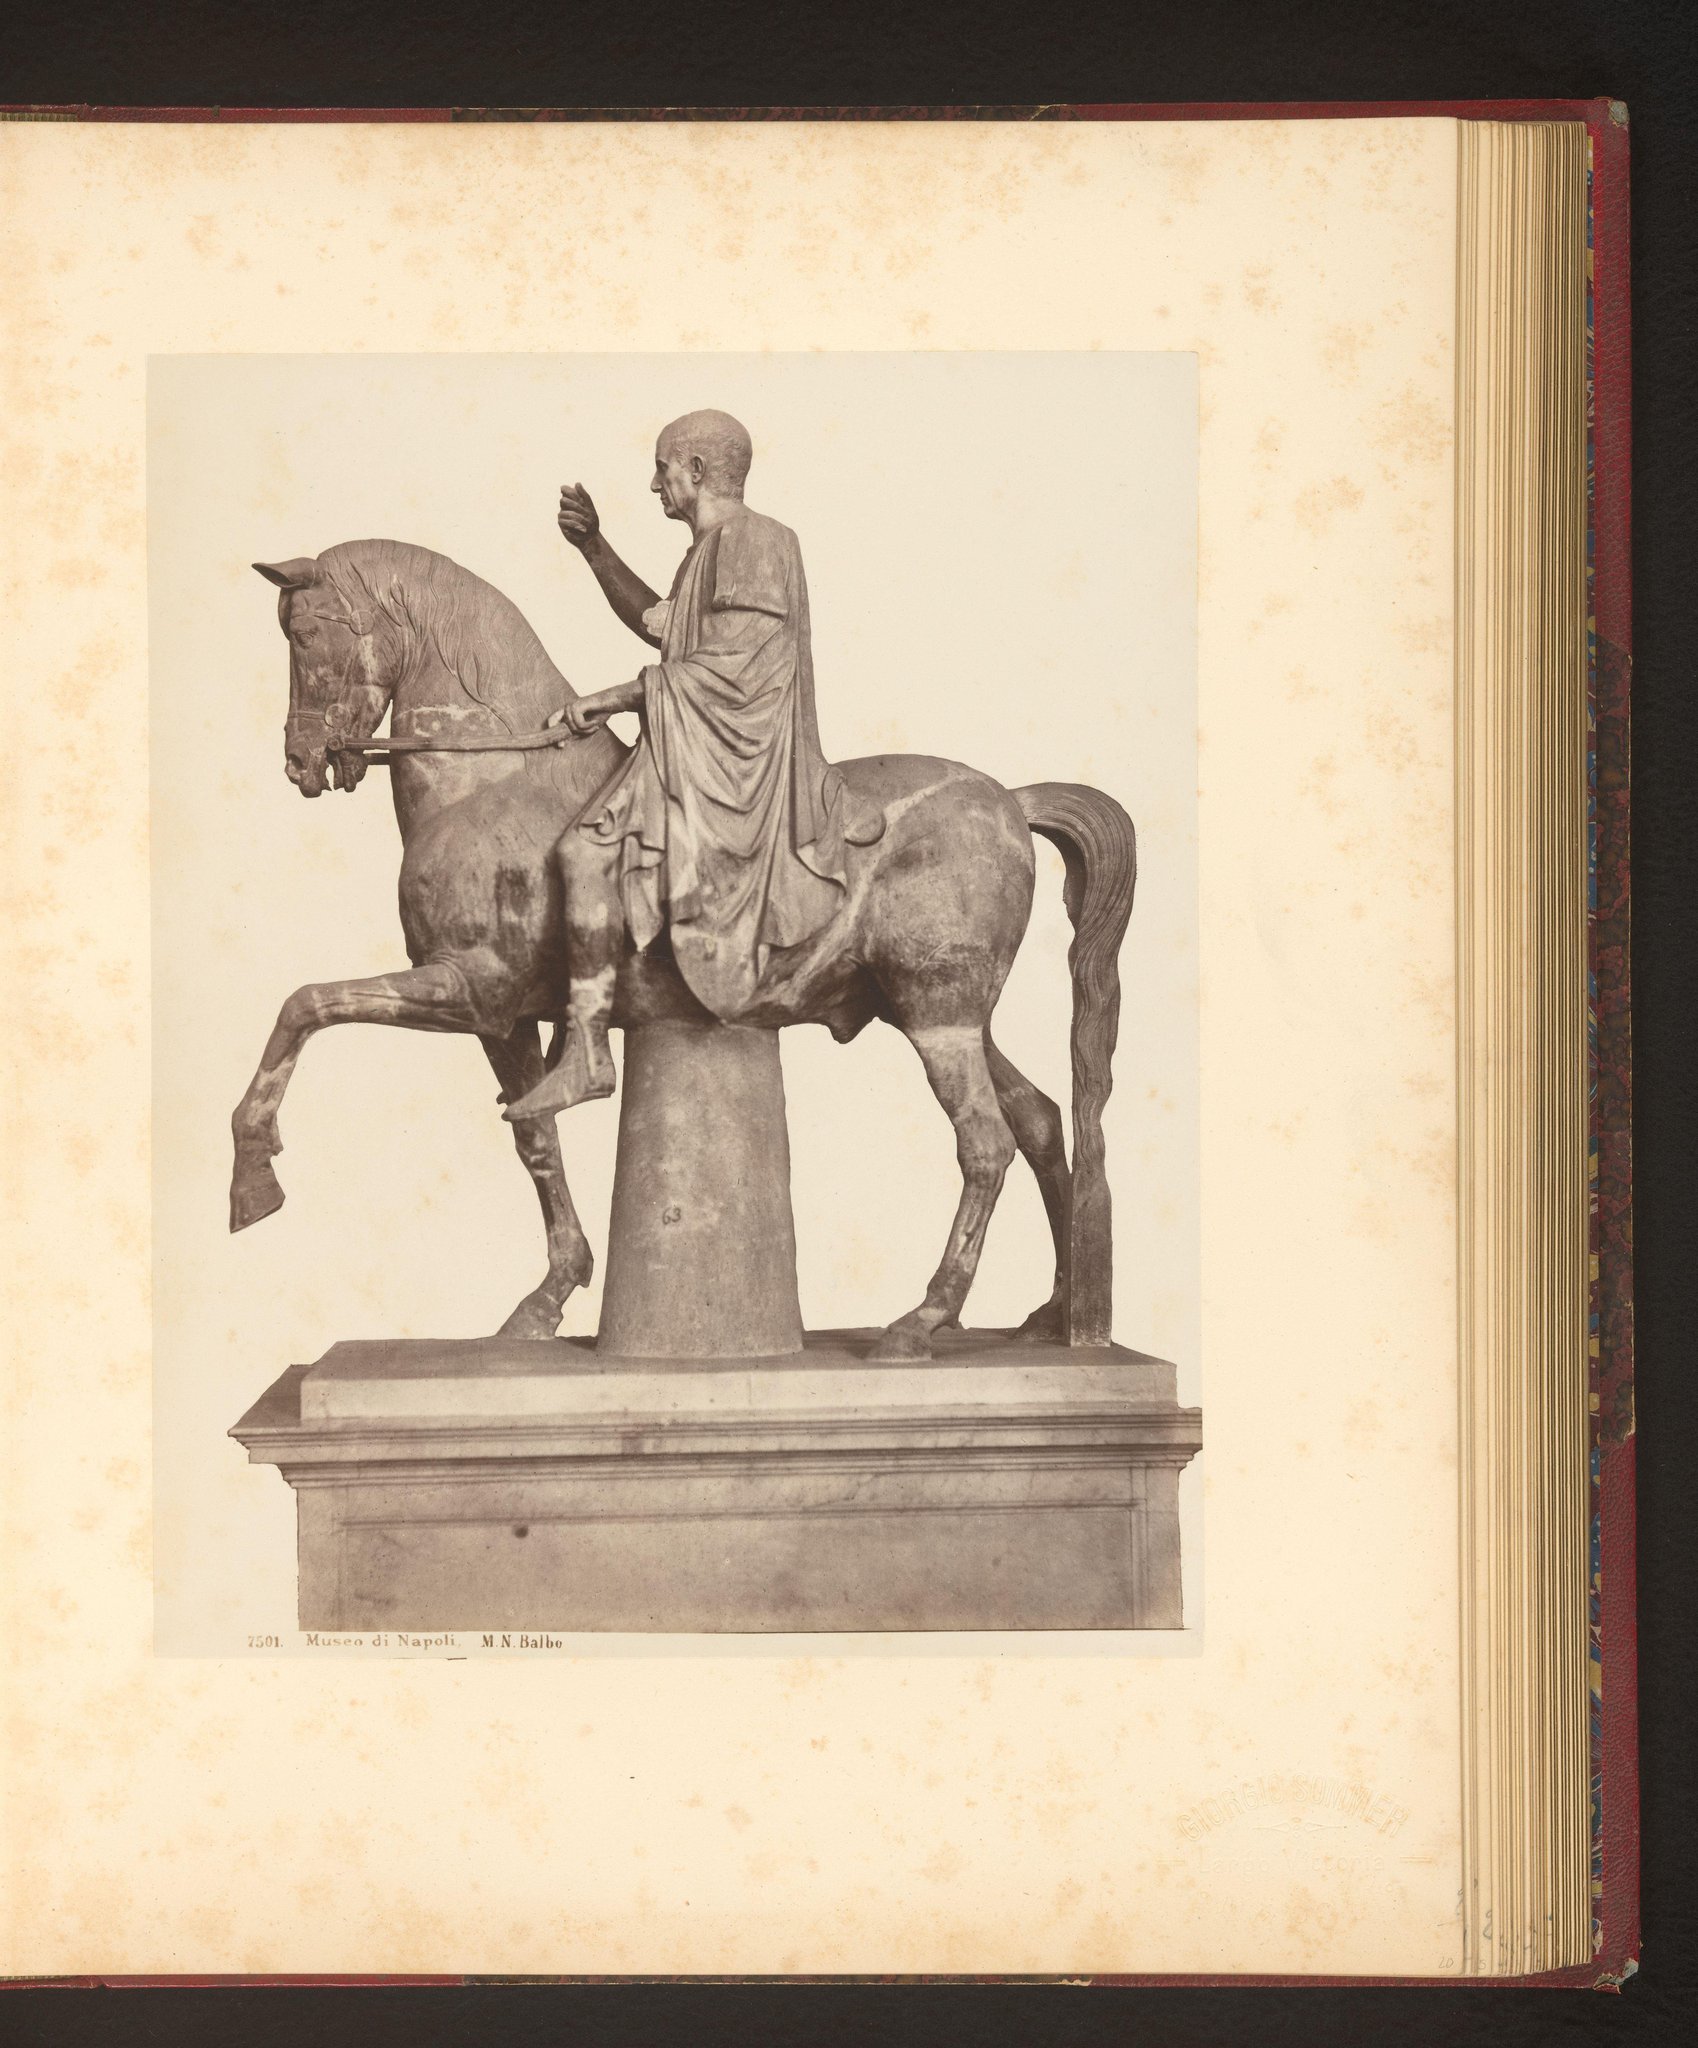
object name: album leaf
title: Museo di Napoli M.N. Balbo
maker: giorgio sommer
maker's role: fotograaf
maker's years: 1834-1914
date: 1874-1879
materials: photographic support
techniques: albumen print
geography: naples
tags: riding a horse, ass, or mule; rider, horseman, sculpture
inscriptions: number: ‘7501’, workshop stamp: ‘Giorgio Sommer/ Largo Vittoria/ Napoli’